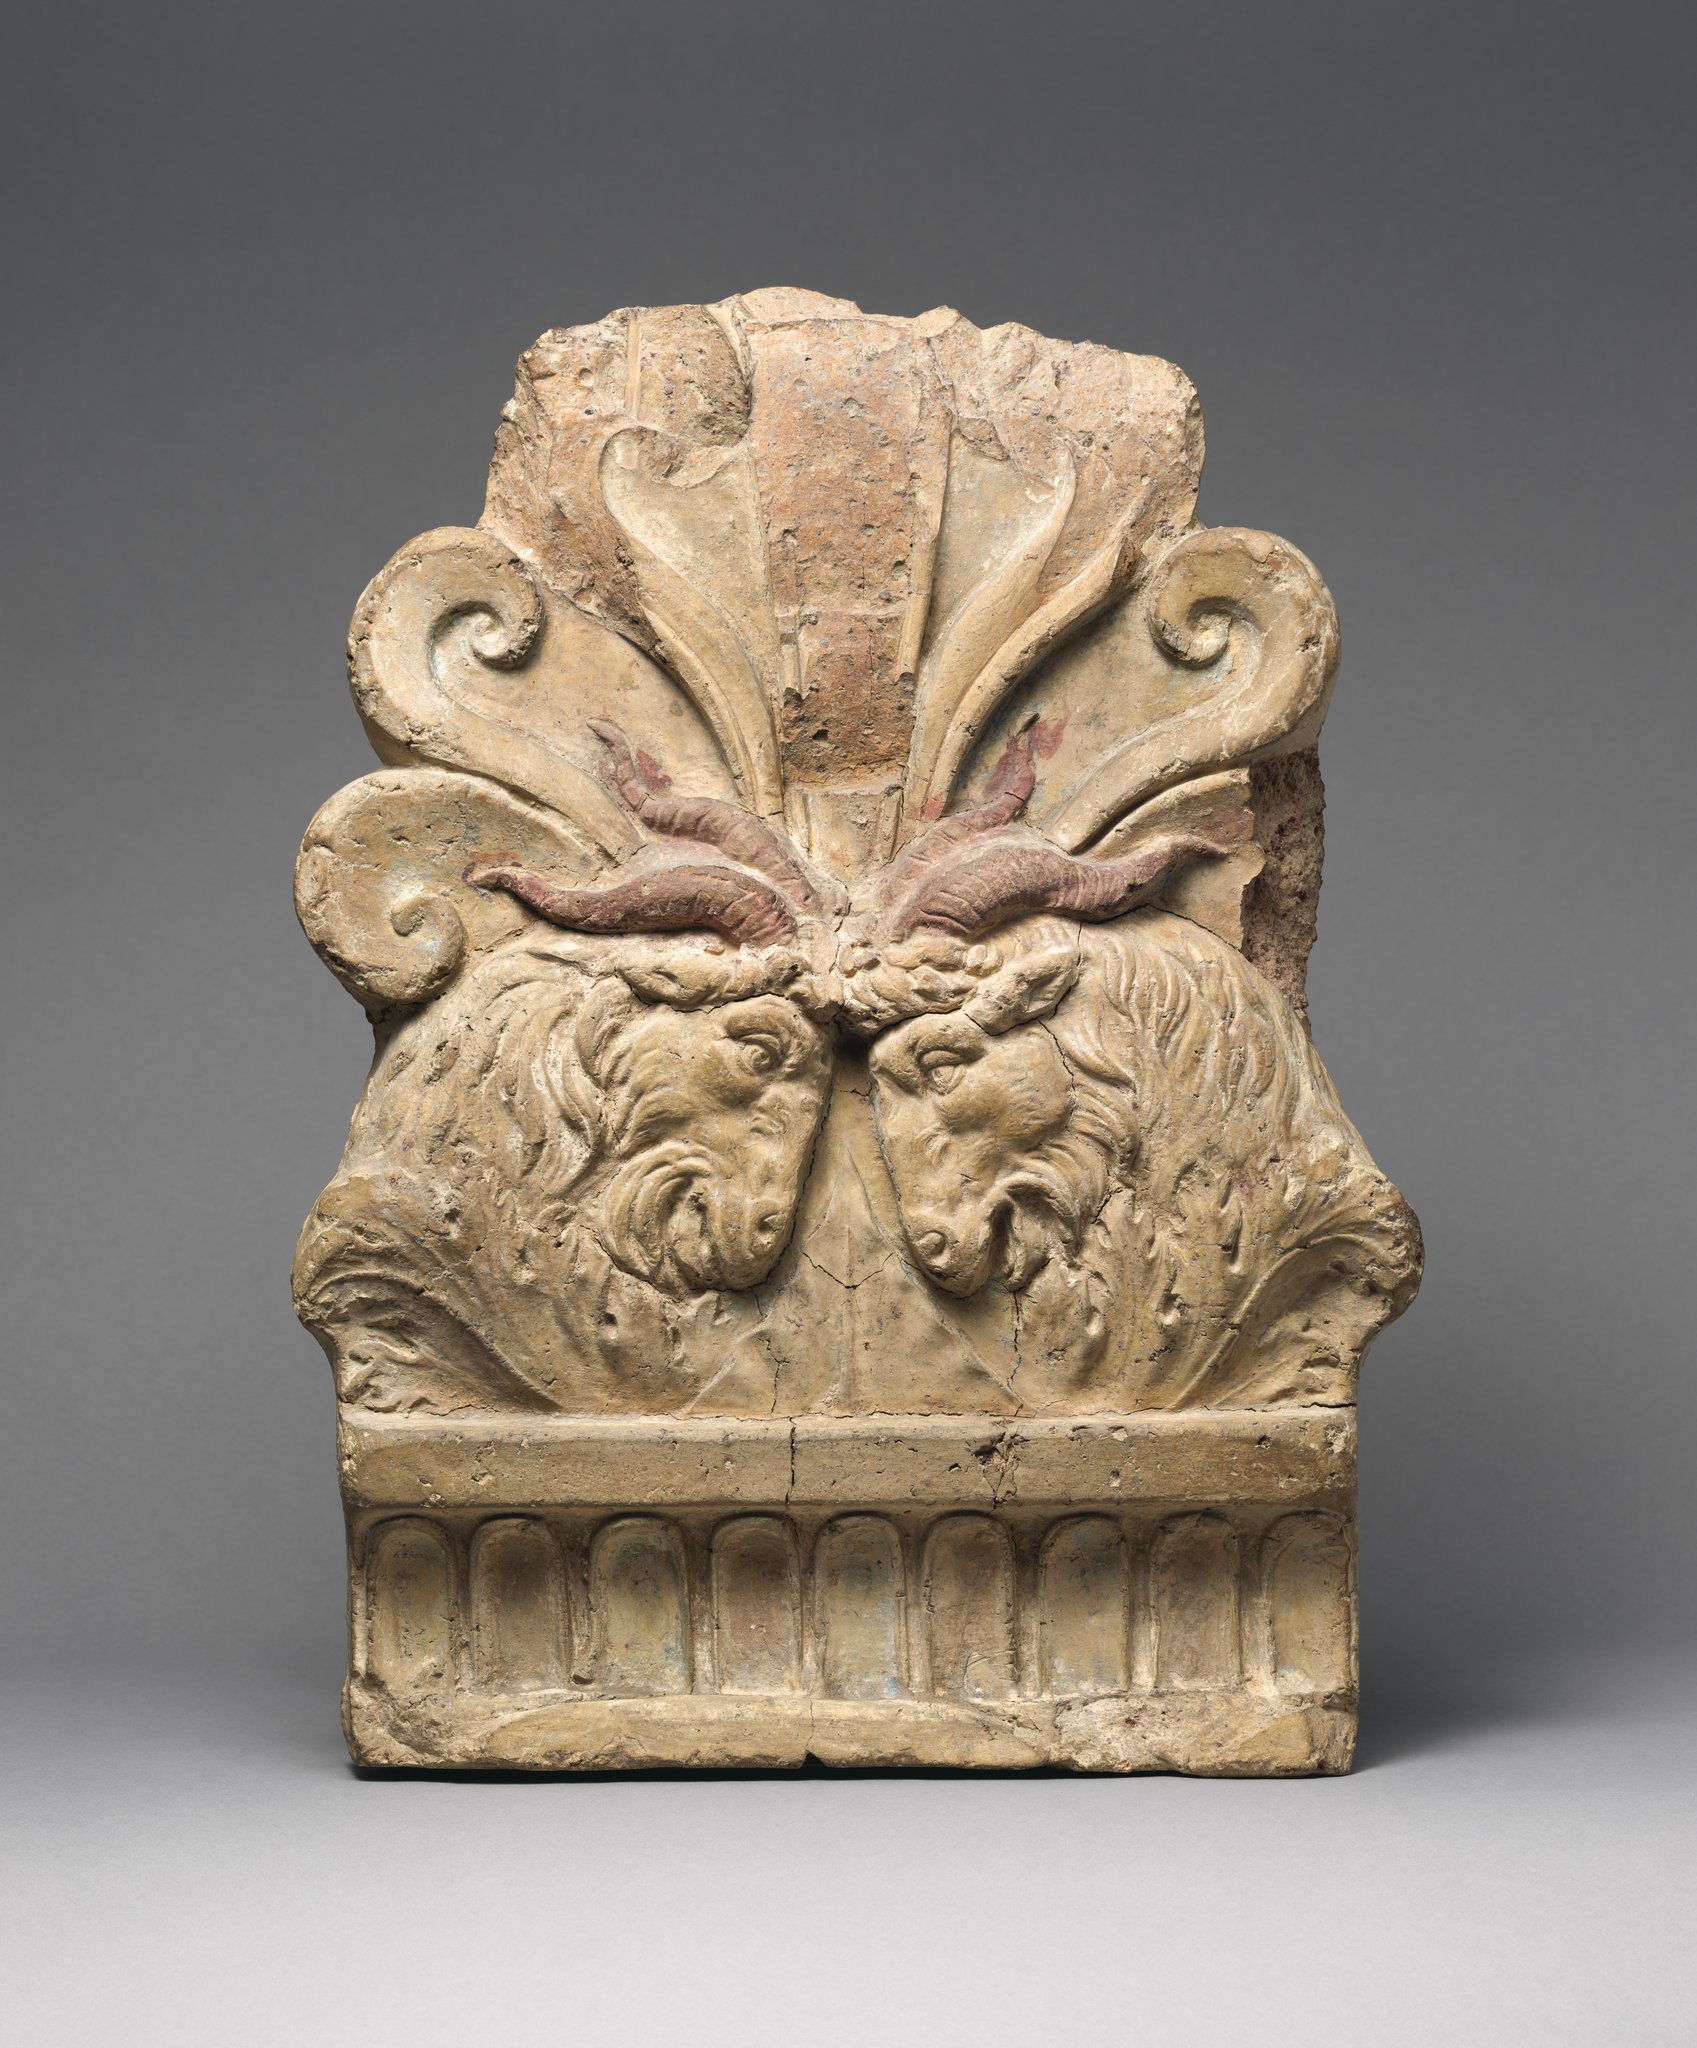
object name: antefix, goats' head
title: Terracotta antefix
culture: roman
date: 34 BCE-33 CE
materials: terracotta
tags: goats